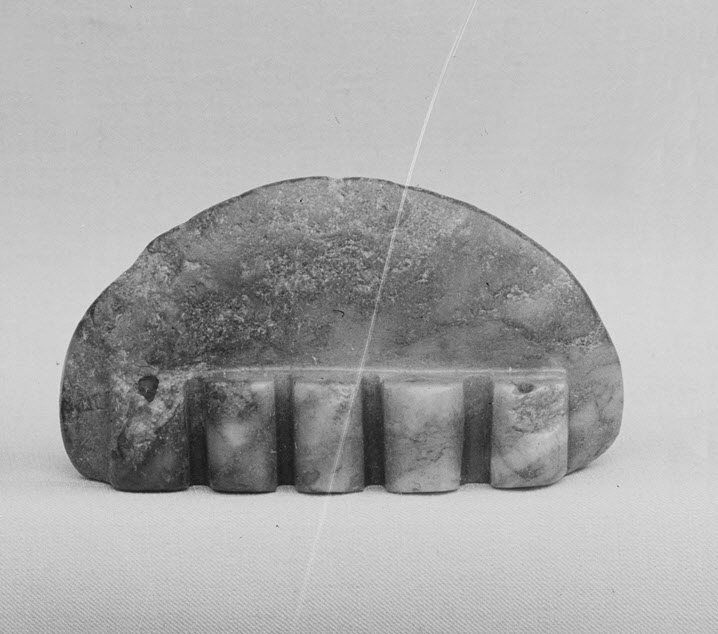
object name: ornament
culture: chinese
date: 1867-1933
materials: jade